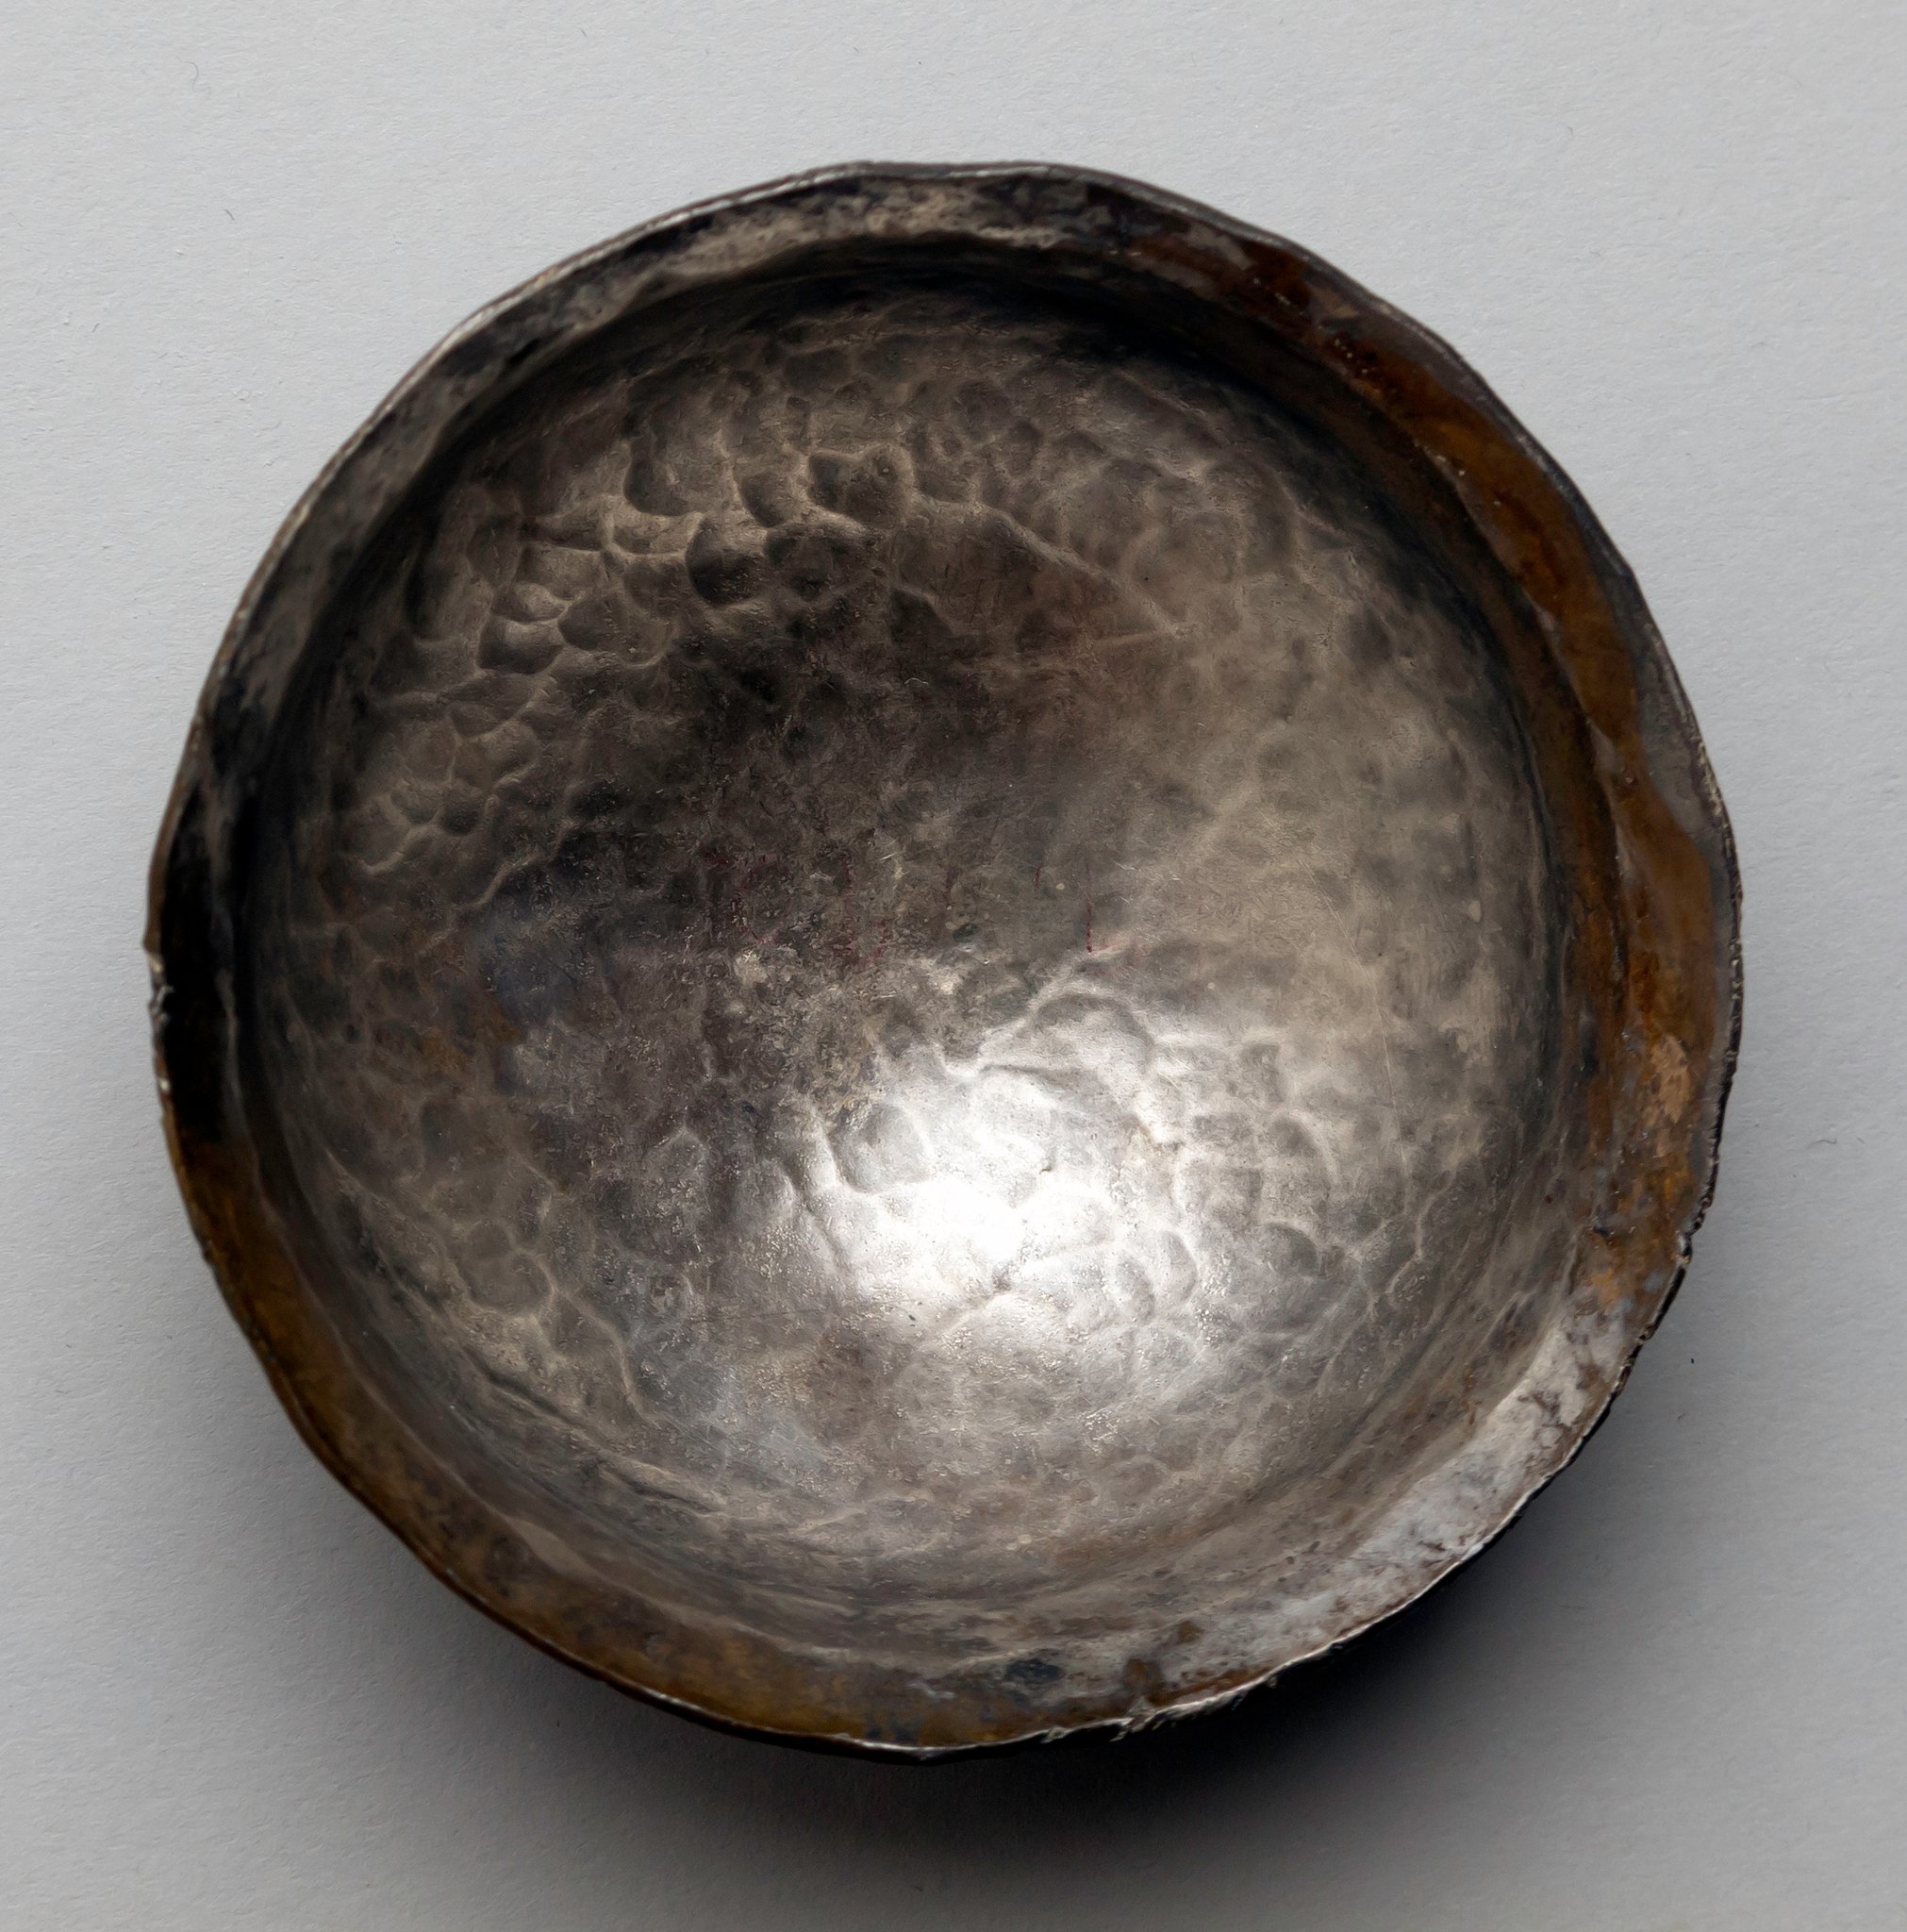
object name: bowl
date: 7000 BCE-330 CE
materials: silver